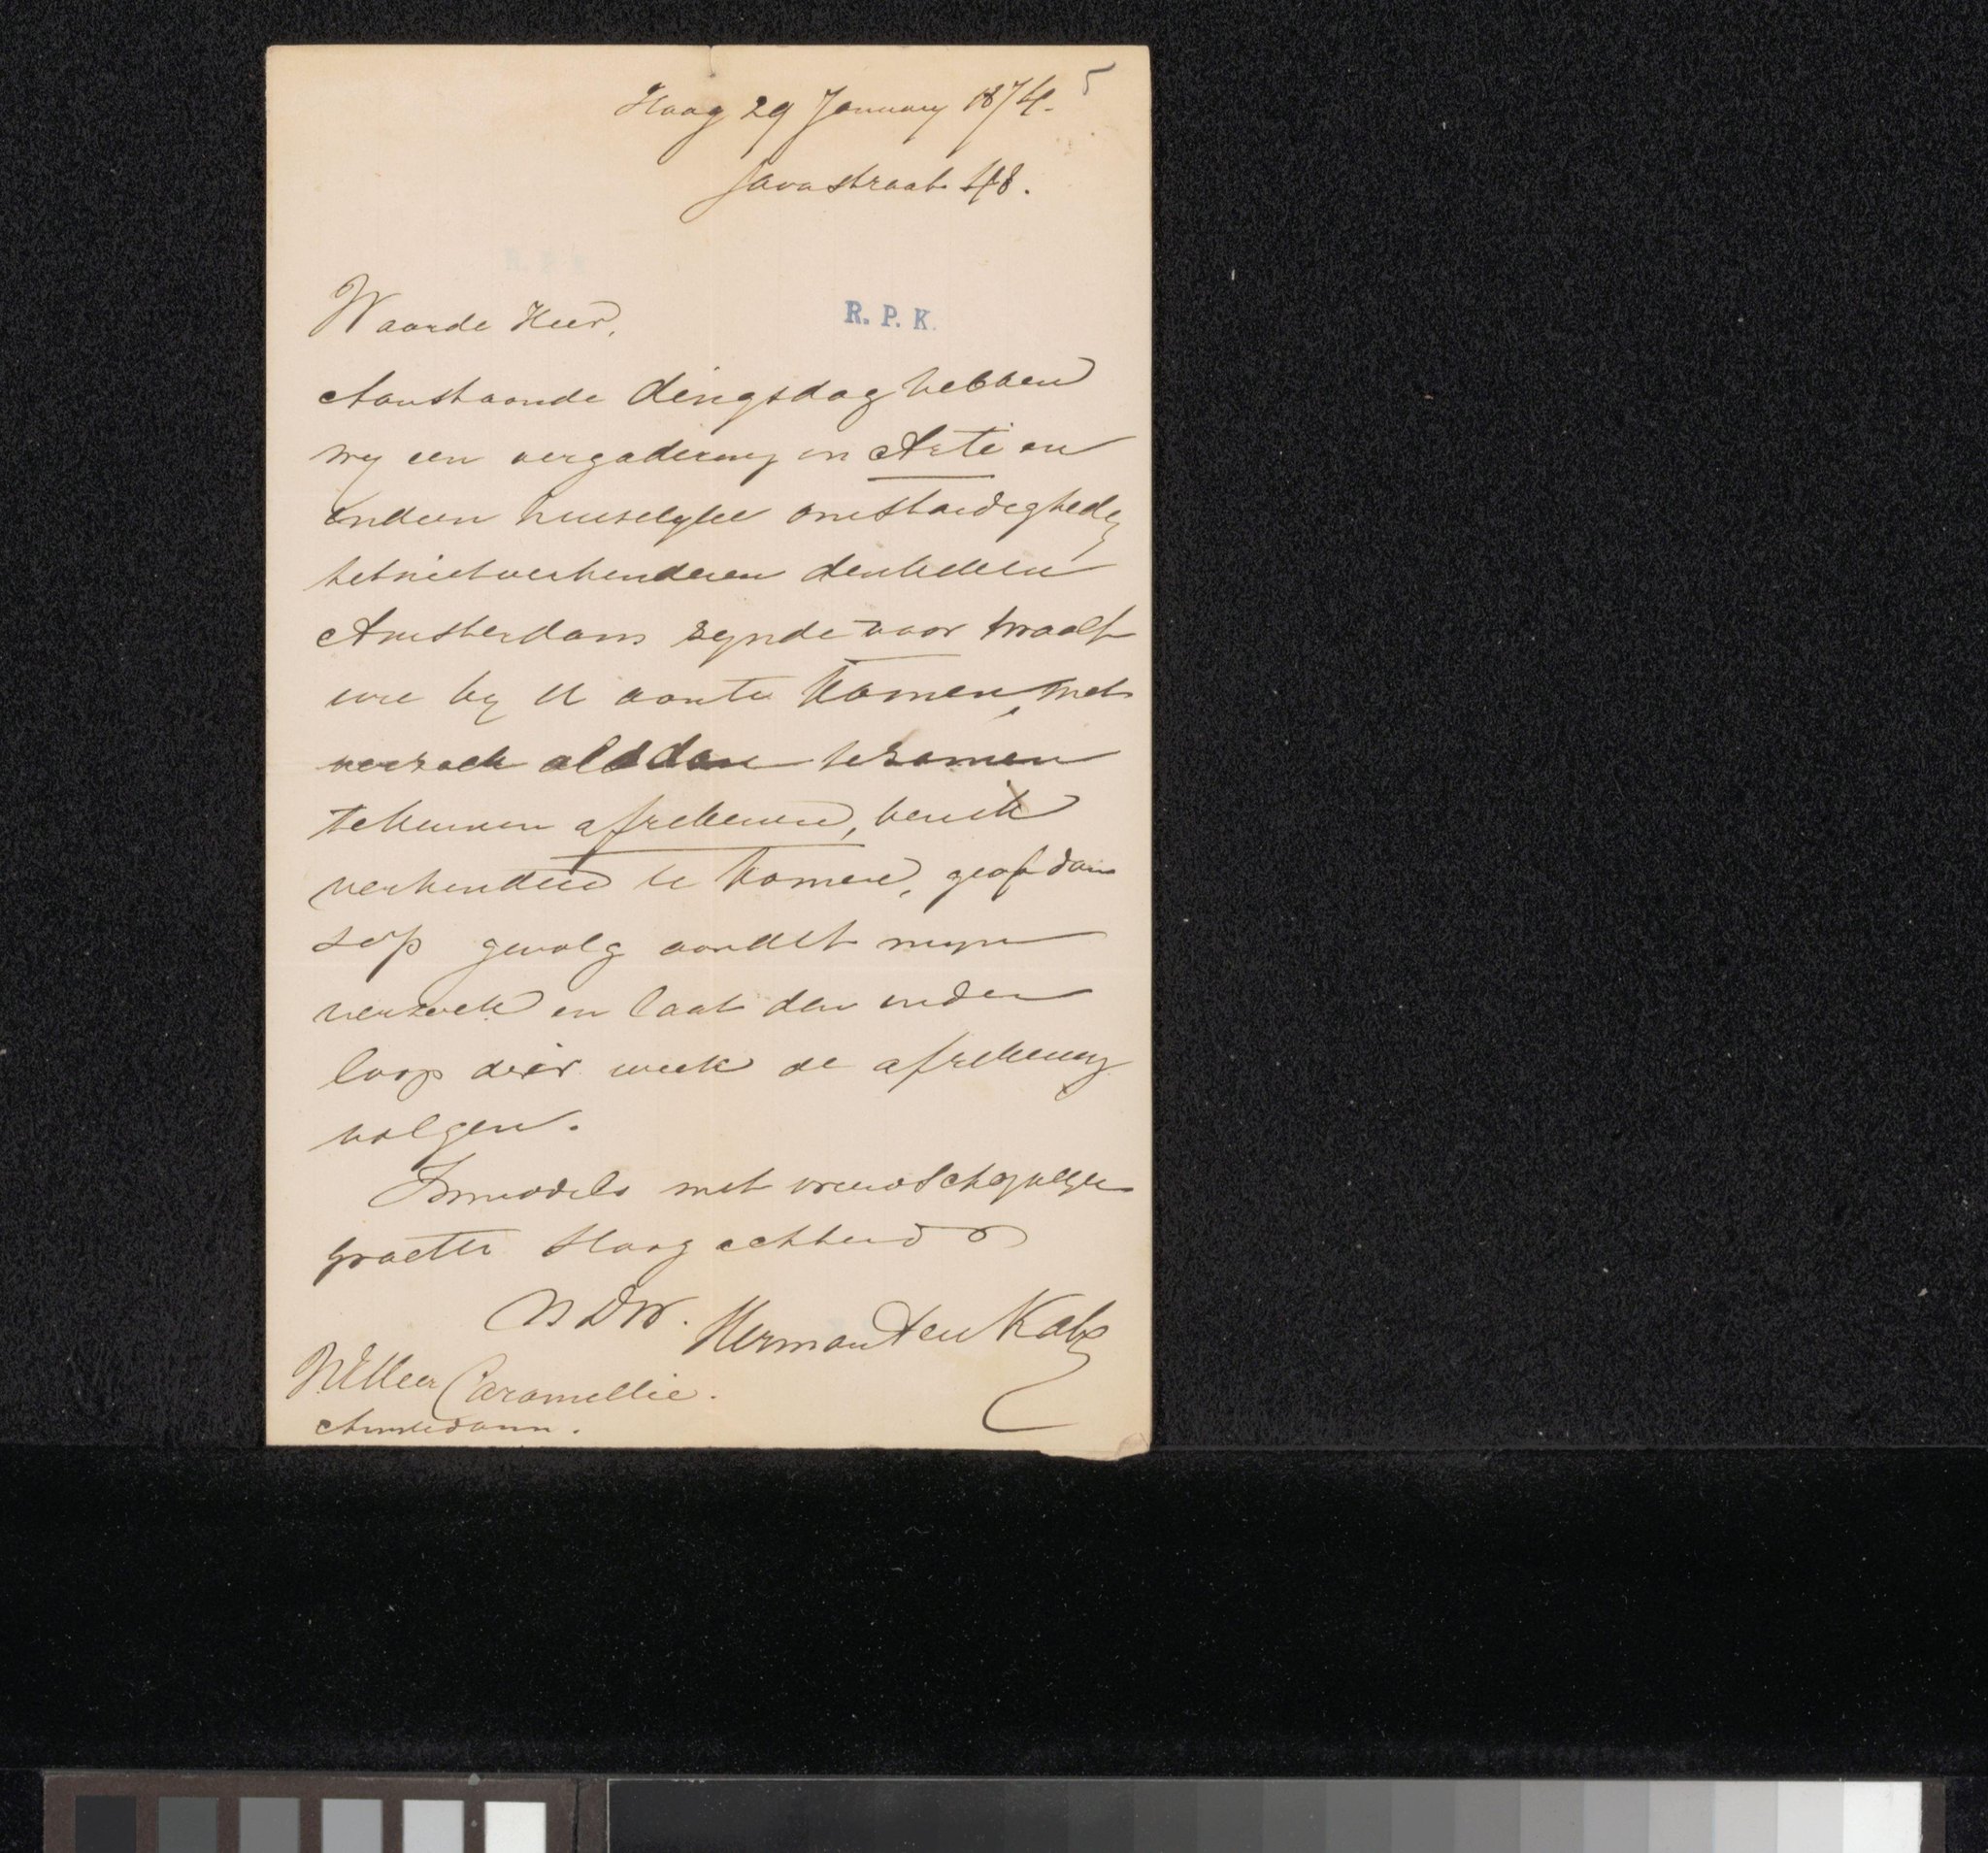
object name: letter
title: Brief aan de heer Caramelli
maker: herman frederik carel ten kate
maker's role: draughtsman, painter, print maker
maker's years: 1822-1891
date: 1874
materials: ink, paper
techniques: pen, writing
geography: the hague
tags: amsterdam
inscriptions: collector's mark: Lugt 2233